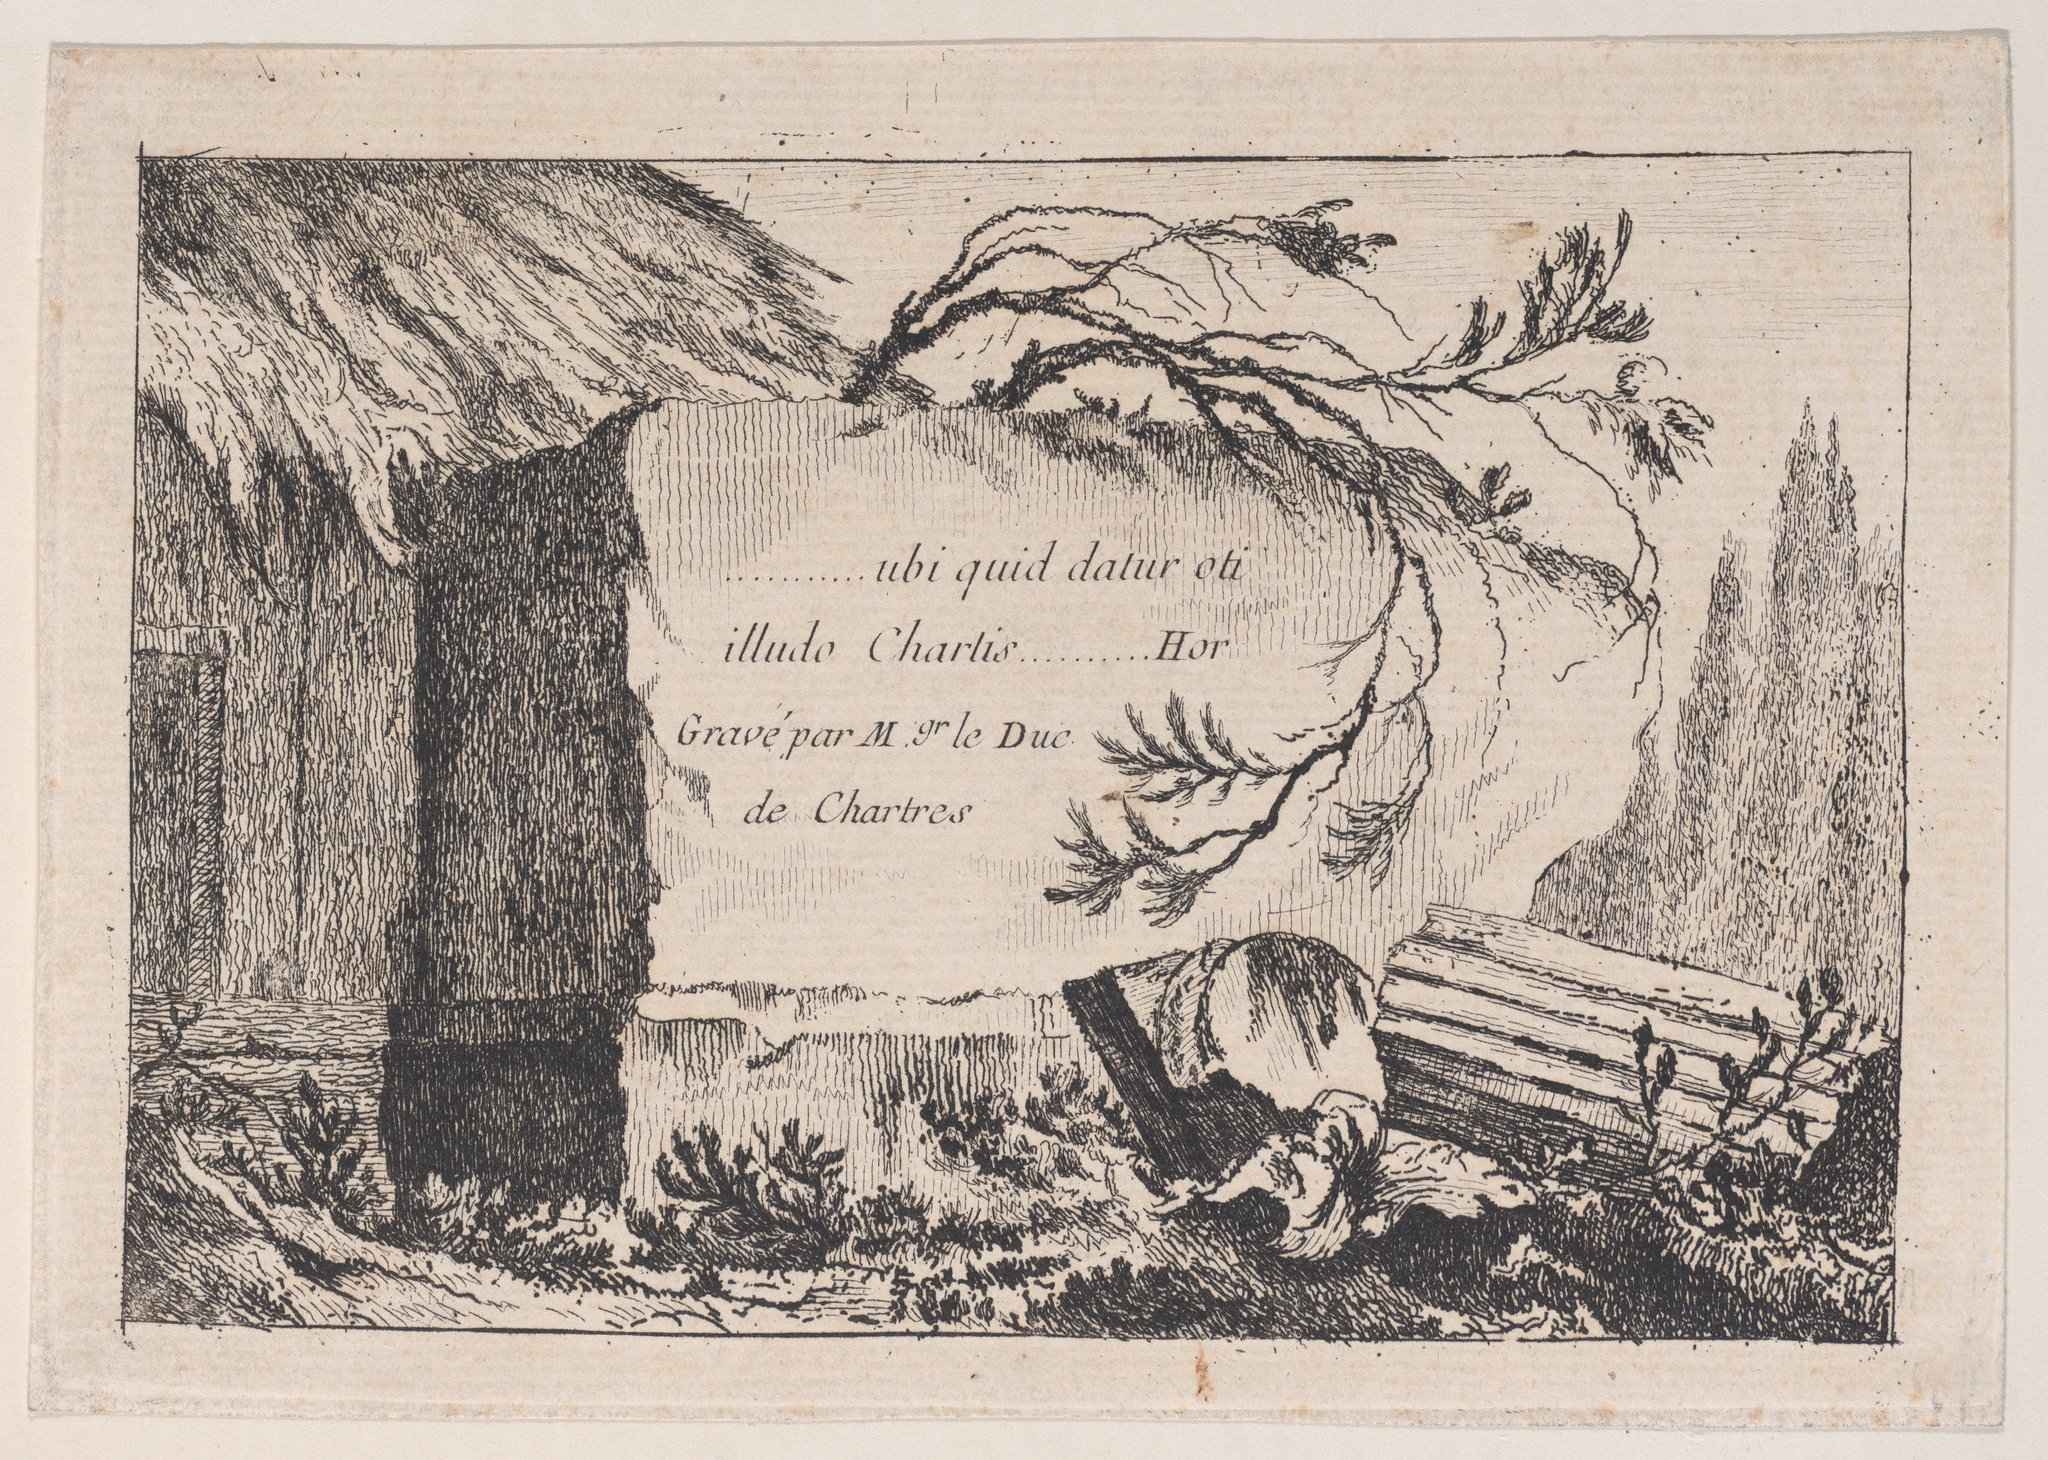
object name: print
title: Title Page to Series of Landscapes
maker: louis philippe joseph, duc de chartres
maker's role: artist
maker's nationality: french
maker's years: 1726-1785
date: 1701-1800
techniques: etching